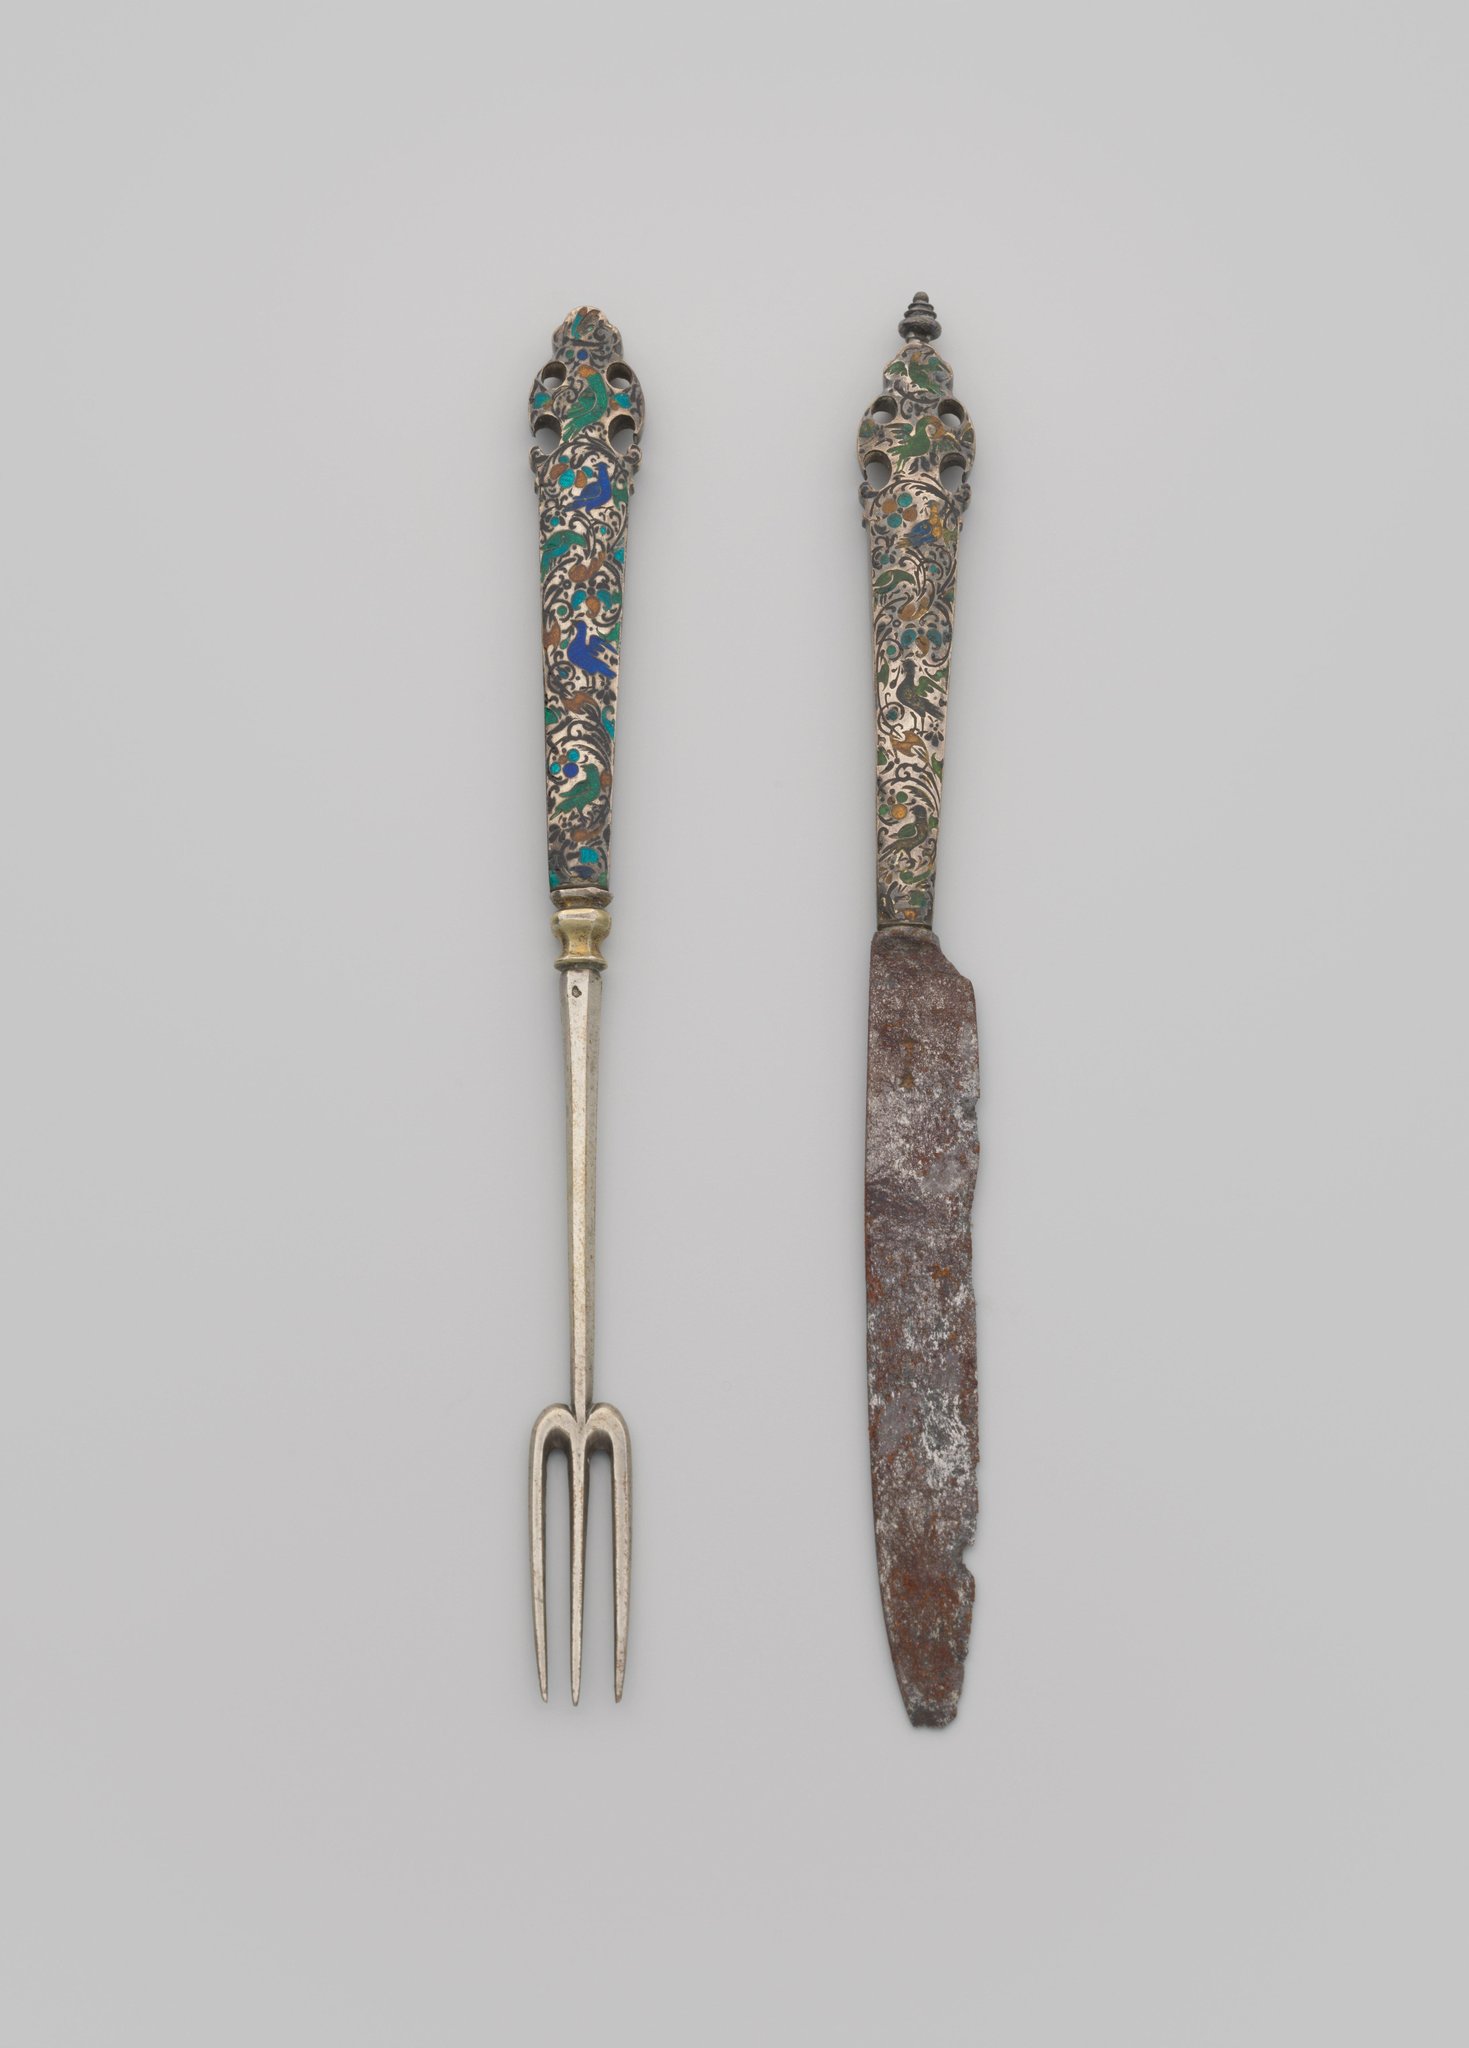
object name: knife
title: Mes met heft eindigend in opengewerkt rolwerkmotief. Bass-taille émail.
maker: Anonymous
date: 1600-1615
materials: iron, silver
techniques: gilding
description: Mes van zilver en ijzer. Het heft verbreedt zich naar het uiteinde toe, en is bekroond met opengewerkt rolwerkmotief. Het is versierd met motieven in bass-taille émail.